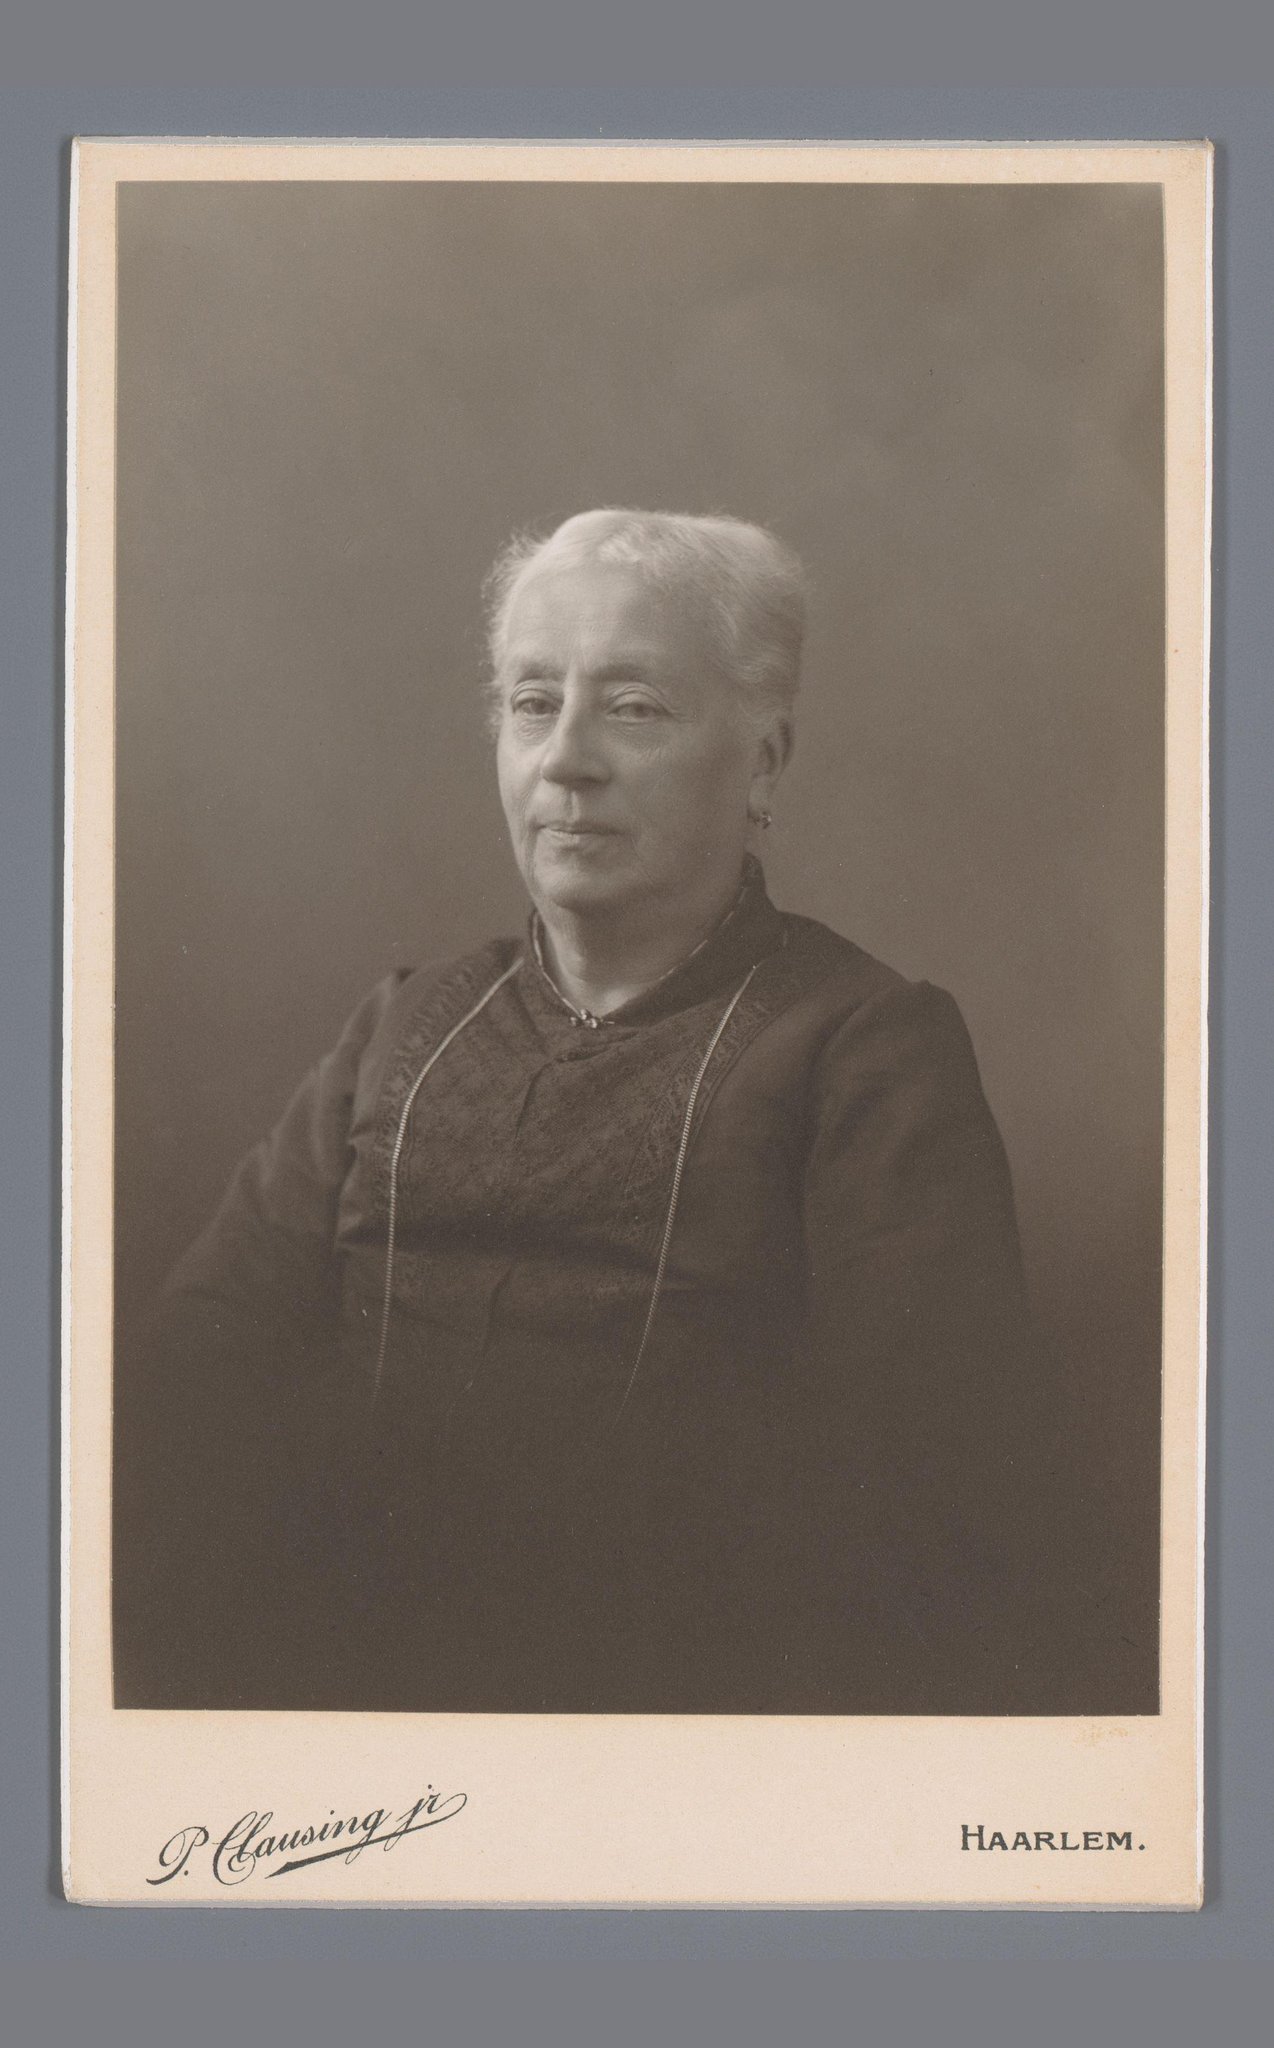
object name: cabinet photograph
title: Portret van een onbekende vrouw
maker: peter clausing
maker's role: fotograaf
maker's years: 1870-1913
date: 1908-1913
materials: cardboard, photographic support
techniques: collodion silver print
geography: haarlem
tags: historical persons - bb - woman, haarlem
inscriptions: workshop stamp: ‘P. Clausing jr/ Haarlem, Baan 9 B’